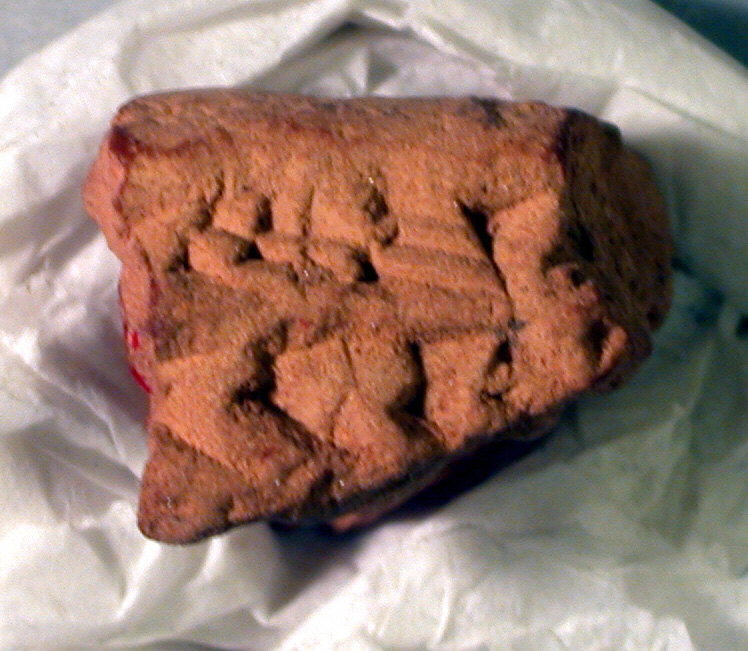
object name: cuneiform tablet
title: Cuneiform tablet: fragment, Ebabbar archive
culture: achaemenid or babylonian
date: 700-301 BCE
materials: clay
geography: mesopotamia